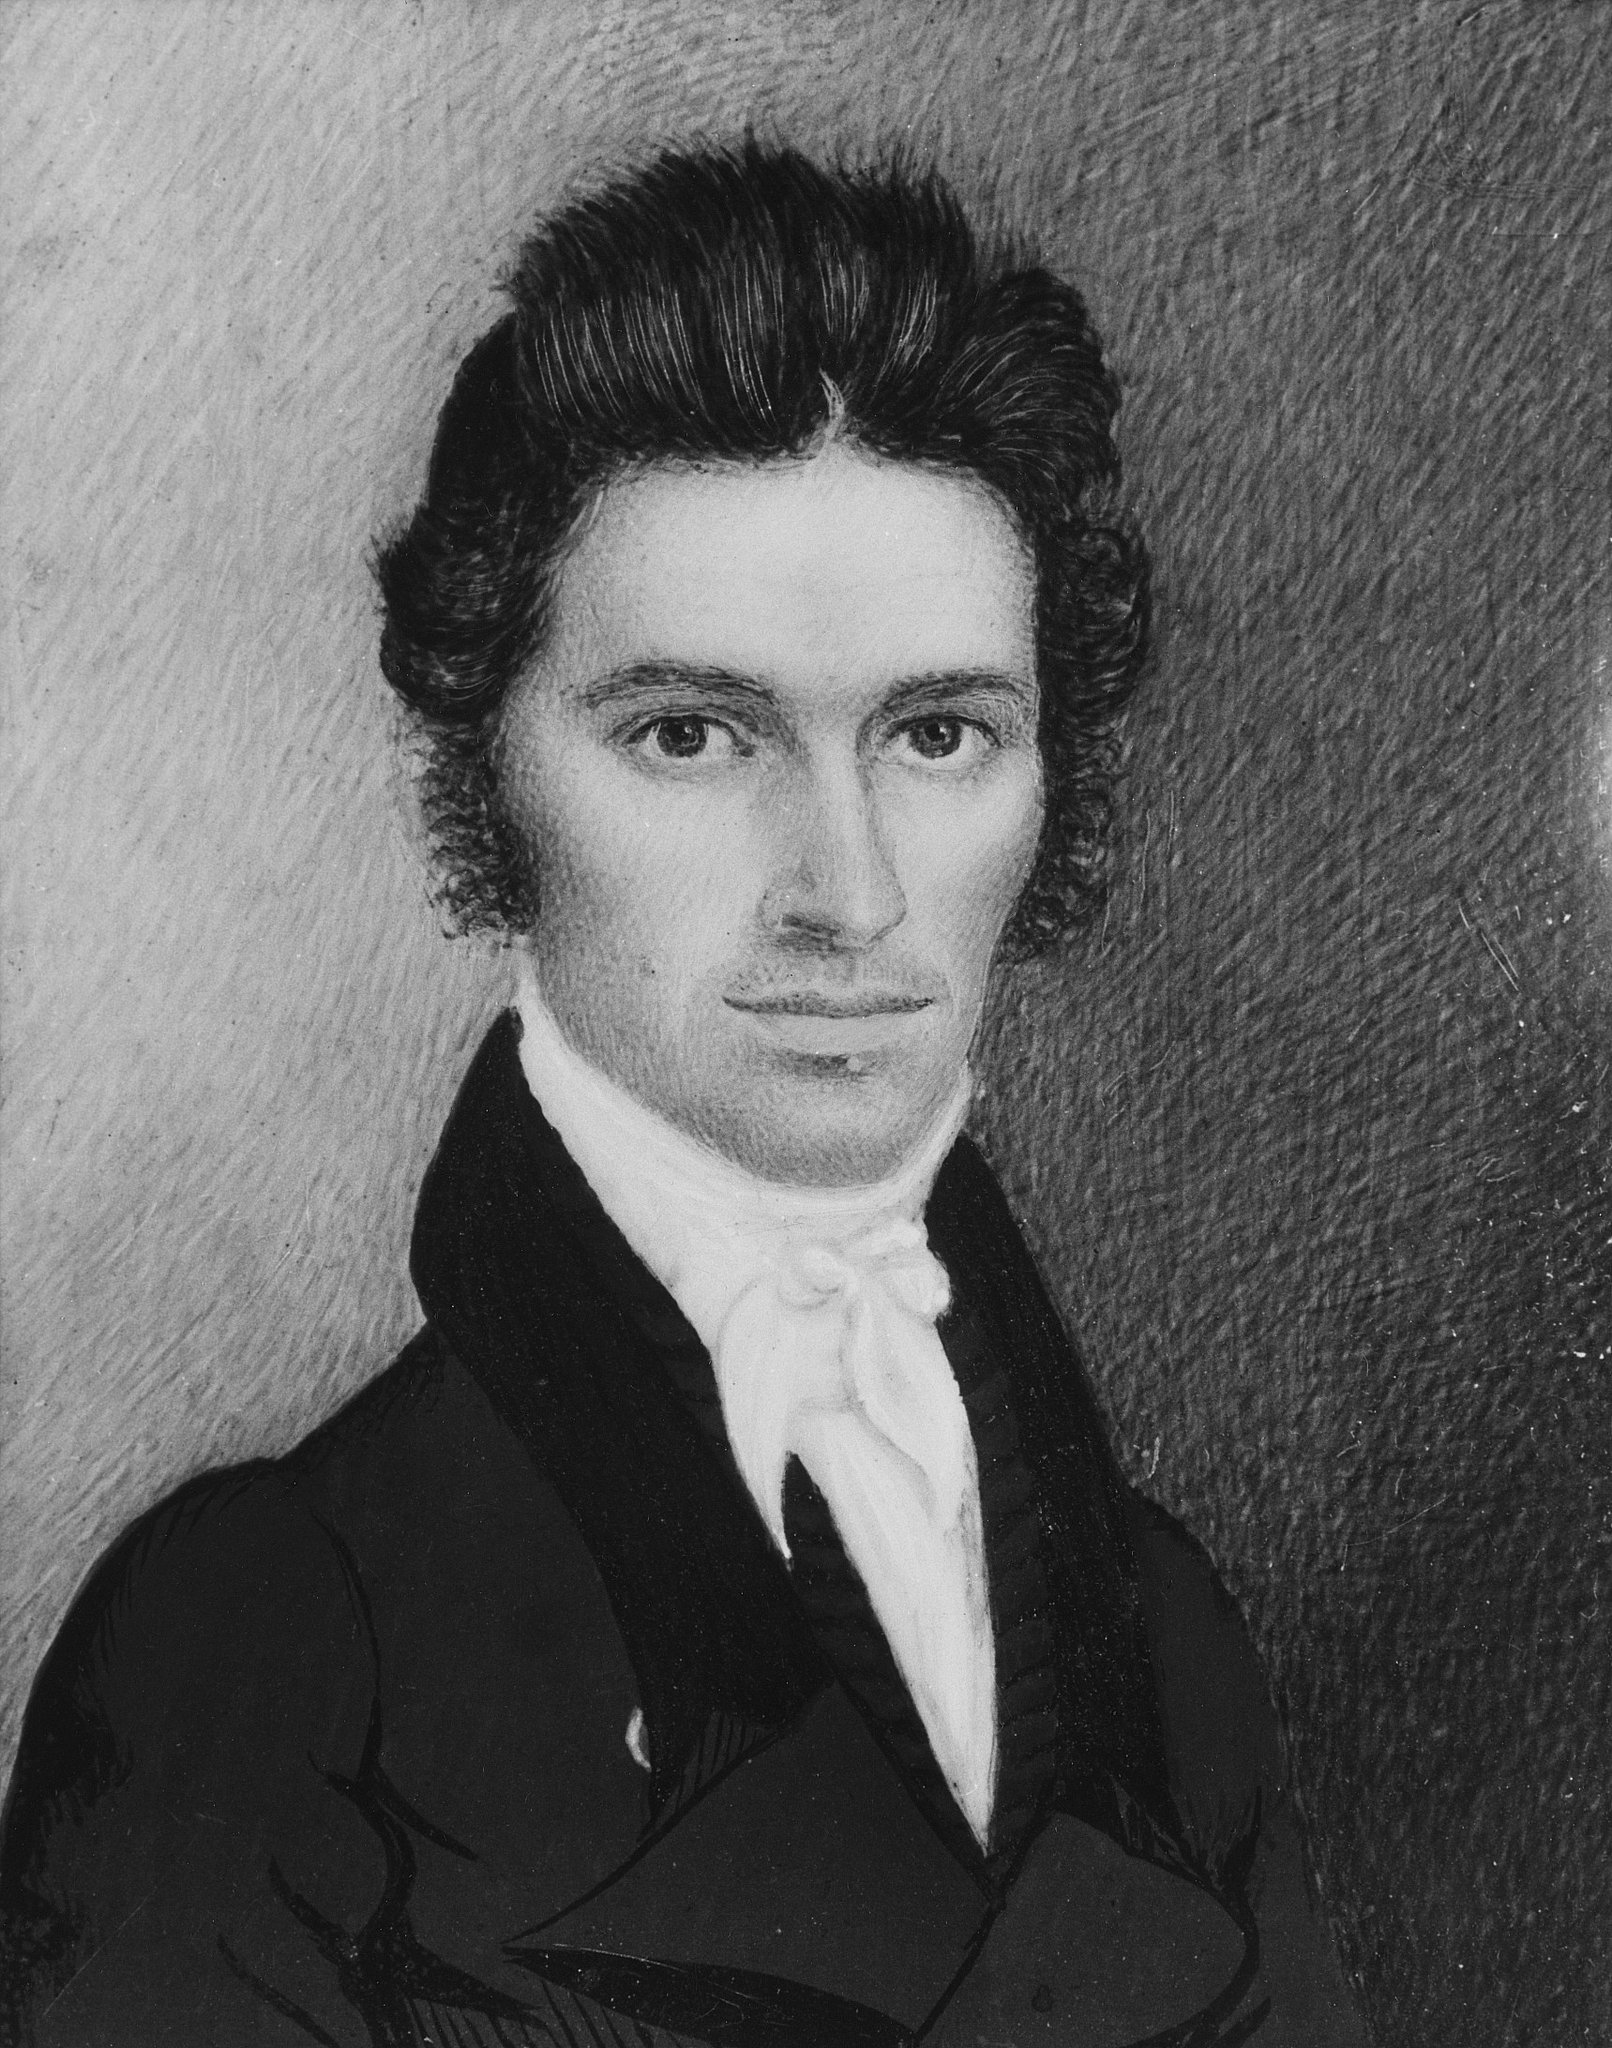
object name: painting, miniature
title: Stephen Danforth Hassam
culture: american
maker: john s. porter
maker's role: artist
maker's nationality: american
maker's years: 1822-1834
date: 1820-1825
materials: ivory, watercolor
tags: men,portraits